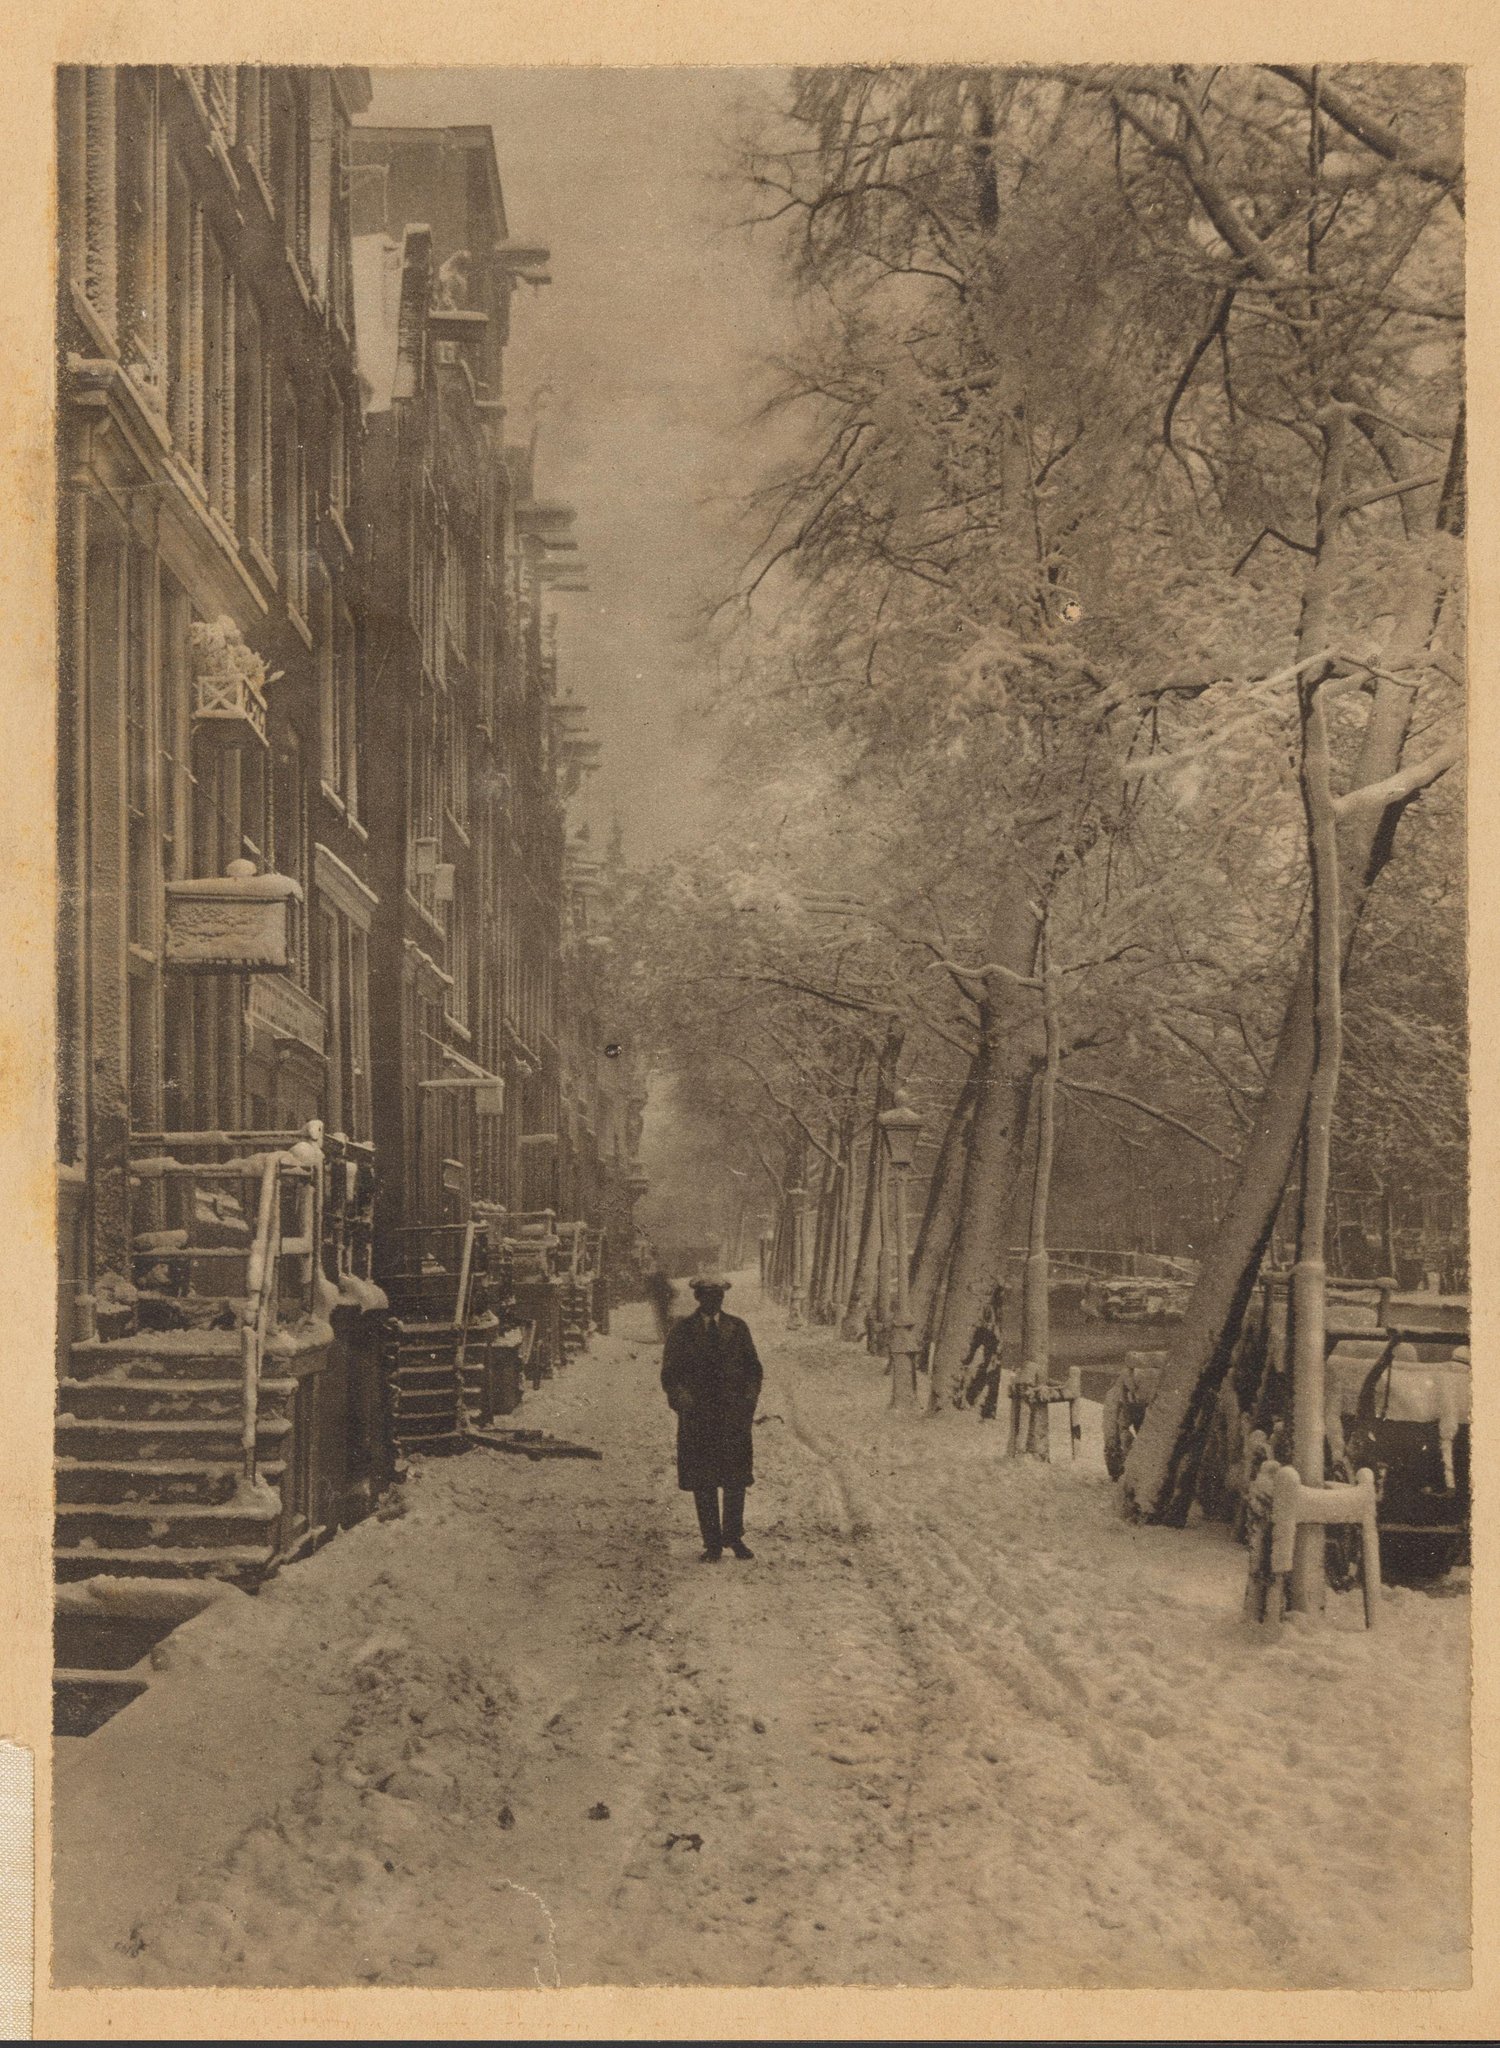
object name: photograph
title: Man wandelend langs besneeuwde gracht, vermoedelijk in Amsterdam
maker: Anonymous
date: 1900-1920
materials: paper, ink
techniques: rotogravure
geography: amsterdam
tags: strolling, adult man, canal, snow, amsterdam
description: Onderdeel van Familiealbum met foto's van een familie in de voormalige kolonie Nederlands-Indië en van een suikerfabriek in Purworejo.